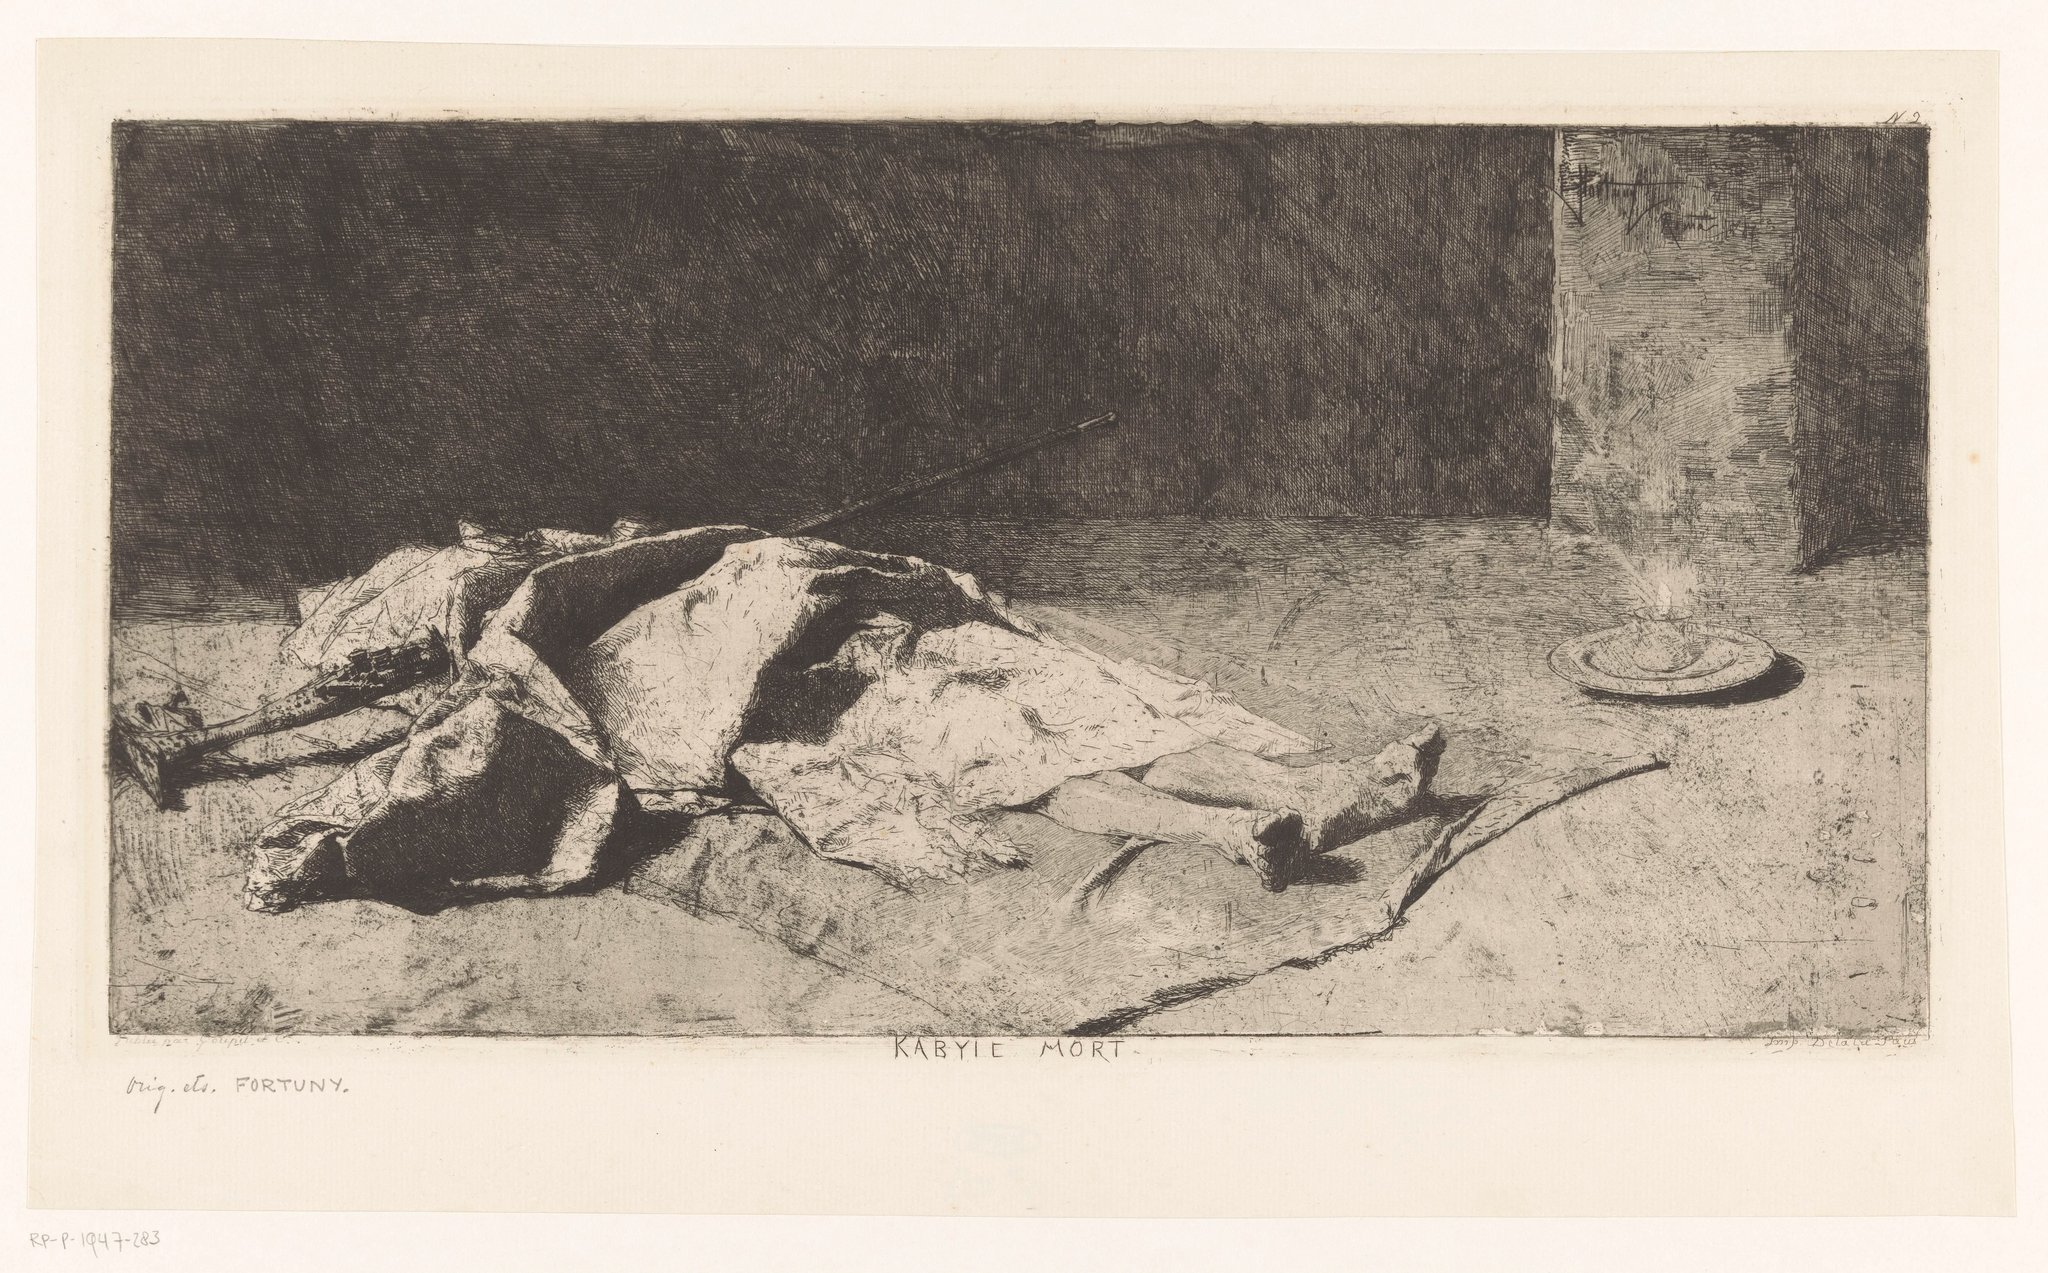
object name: print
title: Dood lichaam van een Kabyle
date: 1867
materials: paper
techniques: aquatint, etching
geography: rome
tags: carpet, rug, candle, the corpse, firearms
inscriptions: collector's mark: Lugt 2228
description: Een dood lichaam liggend op een kleed en bedekt door een doek. Op het lichaam een geweer. Naast het lichaam op de grond een brandende kaars.